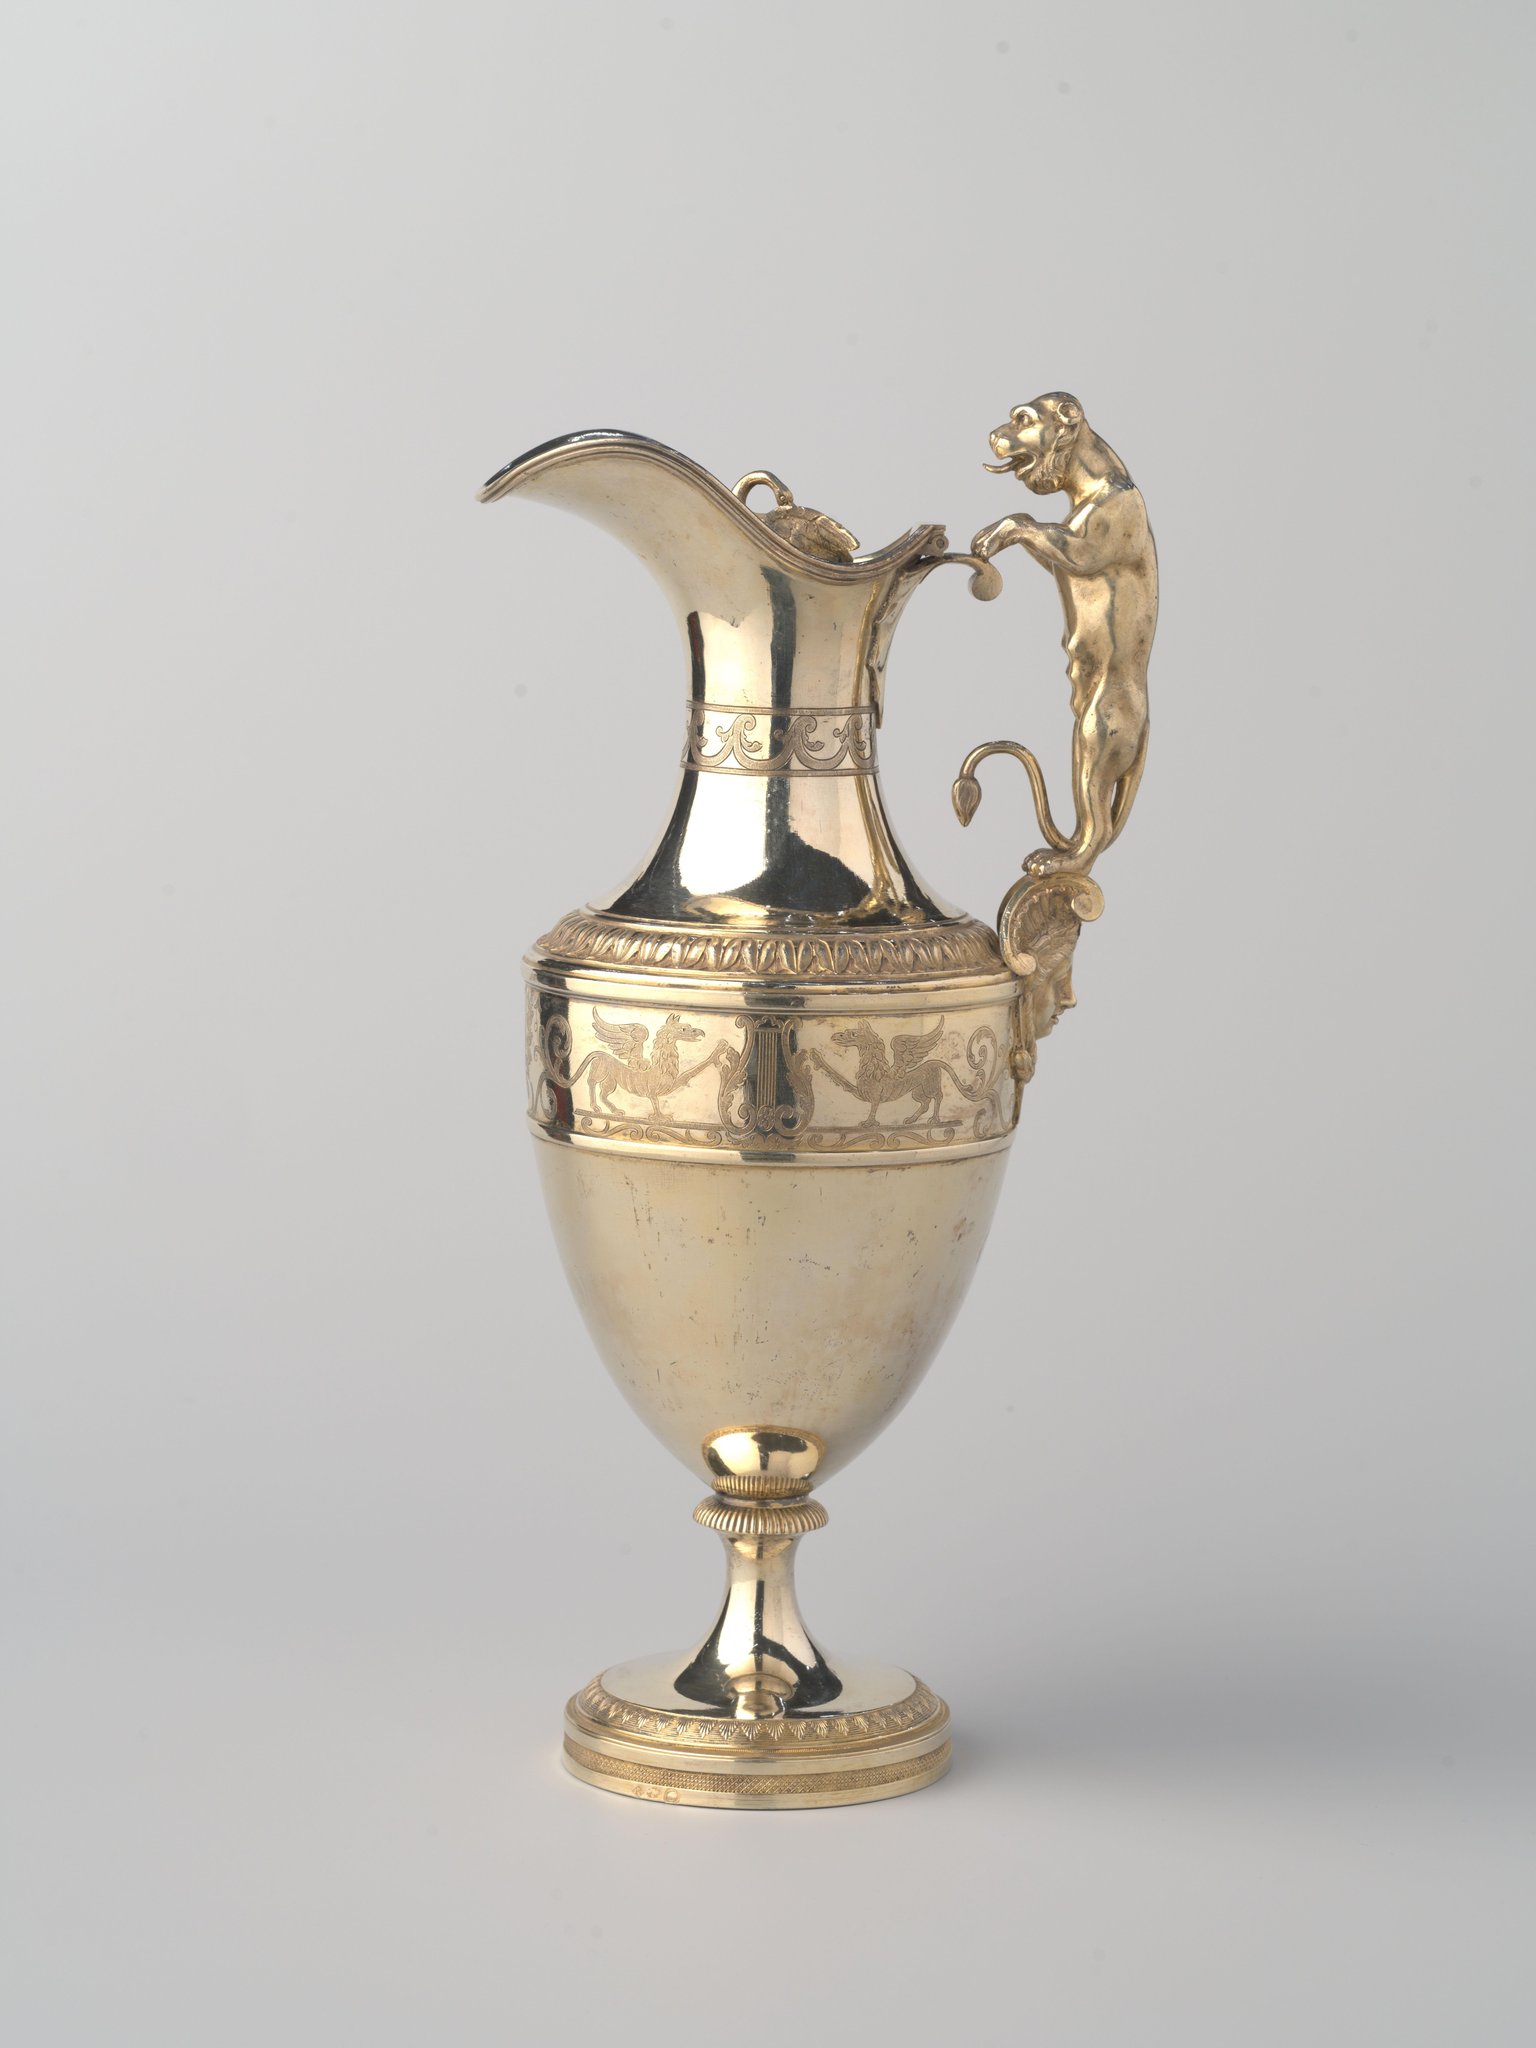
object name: ewer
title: Kan met op het deksel een liggende zwaan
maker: abel etienne giroux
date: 1798-1809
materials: silver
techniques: gilding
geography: paris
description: Sir Thomas Lawrence (1769 - 1830). Willem Ferdinand Mogge Muilman (1778 - 1849), president of the Bank of the Netherlands. Jonkheer J.S.H. van de Poll bequest, Amsterdam, 1880. Ewer and basin. Silver gilt. Paris, c. 1809, by Abel-Etienne Giroux. Dressing table. Oak, veneered with mahogany, gilt bronze mounts. Amsterdam, 1809, by Carel Breytspraak. Made for the bedchamber of Prince Napoleon Louis, the son of King Louis Napoleon, in the Royal Palace on Dam Square in Amsterdam. On loan from H.M. the Queen, Royal Palace, Amsterdam.